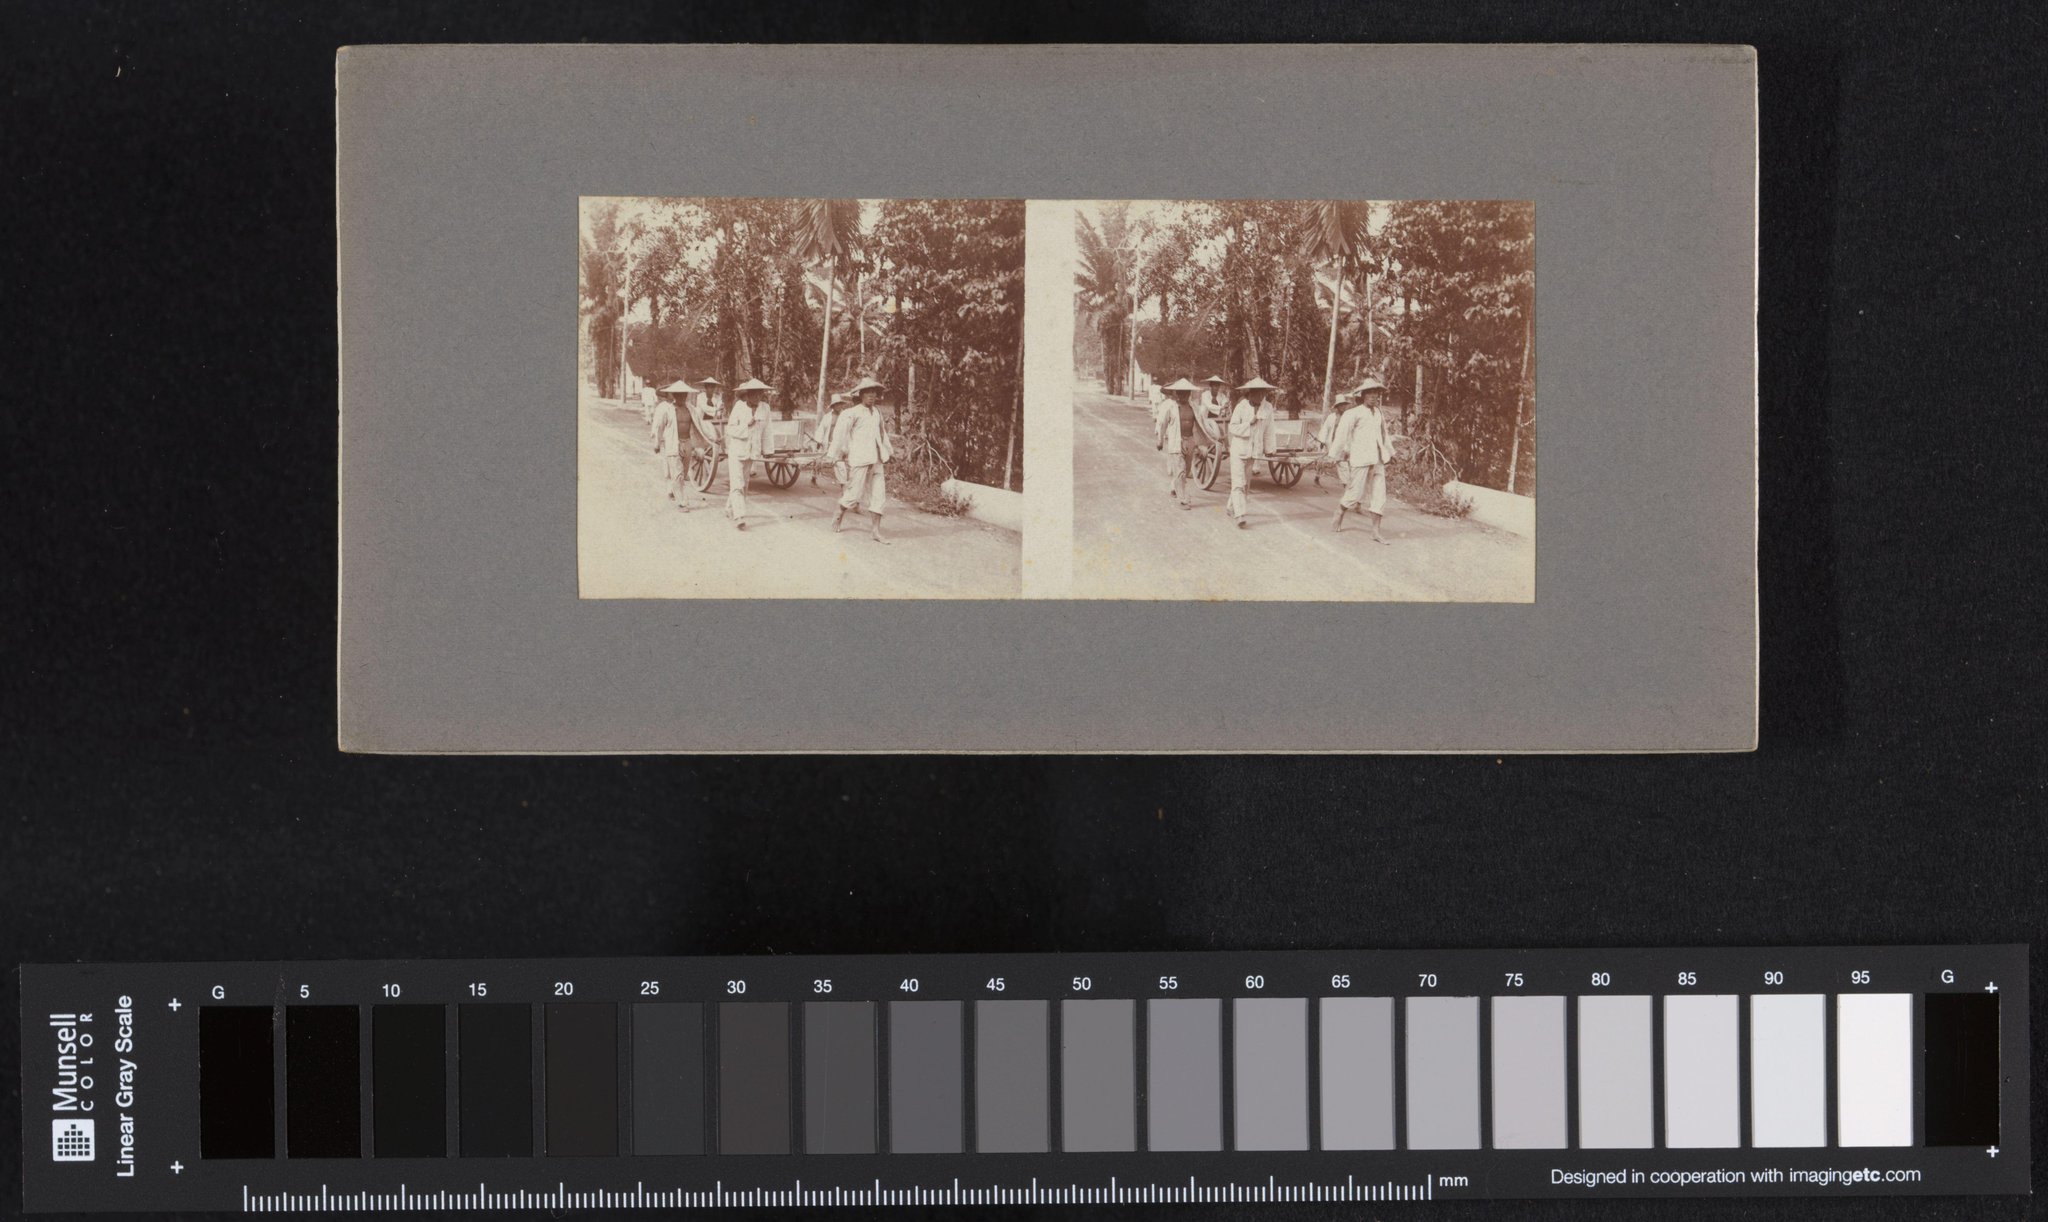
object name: stereograph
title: Handkar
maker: robert julius boers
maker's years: 1867-1932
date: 1900-1922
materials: cardboard, photographic support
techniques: gelatin silver print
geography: bangka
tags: robert julius boers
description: Handkar op straat getrokken door acht Indische mannen in het wit, mogelijk een begrafenis, waarschijnlijk op Banka. Onderdeel van een groep stereofoto's van Robert Julius Boers, chef van het staatsbedrijf de Banka-tinwinning op Banka, uit de periode ca. 1900-1922.